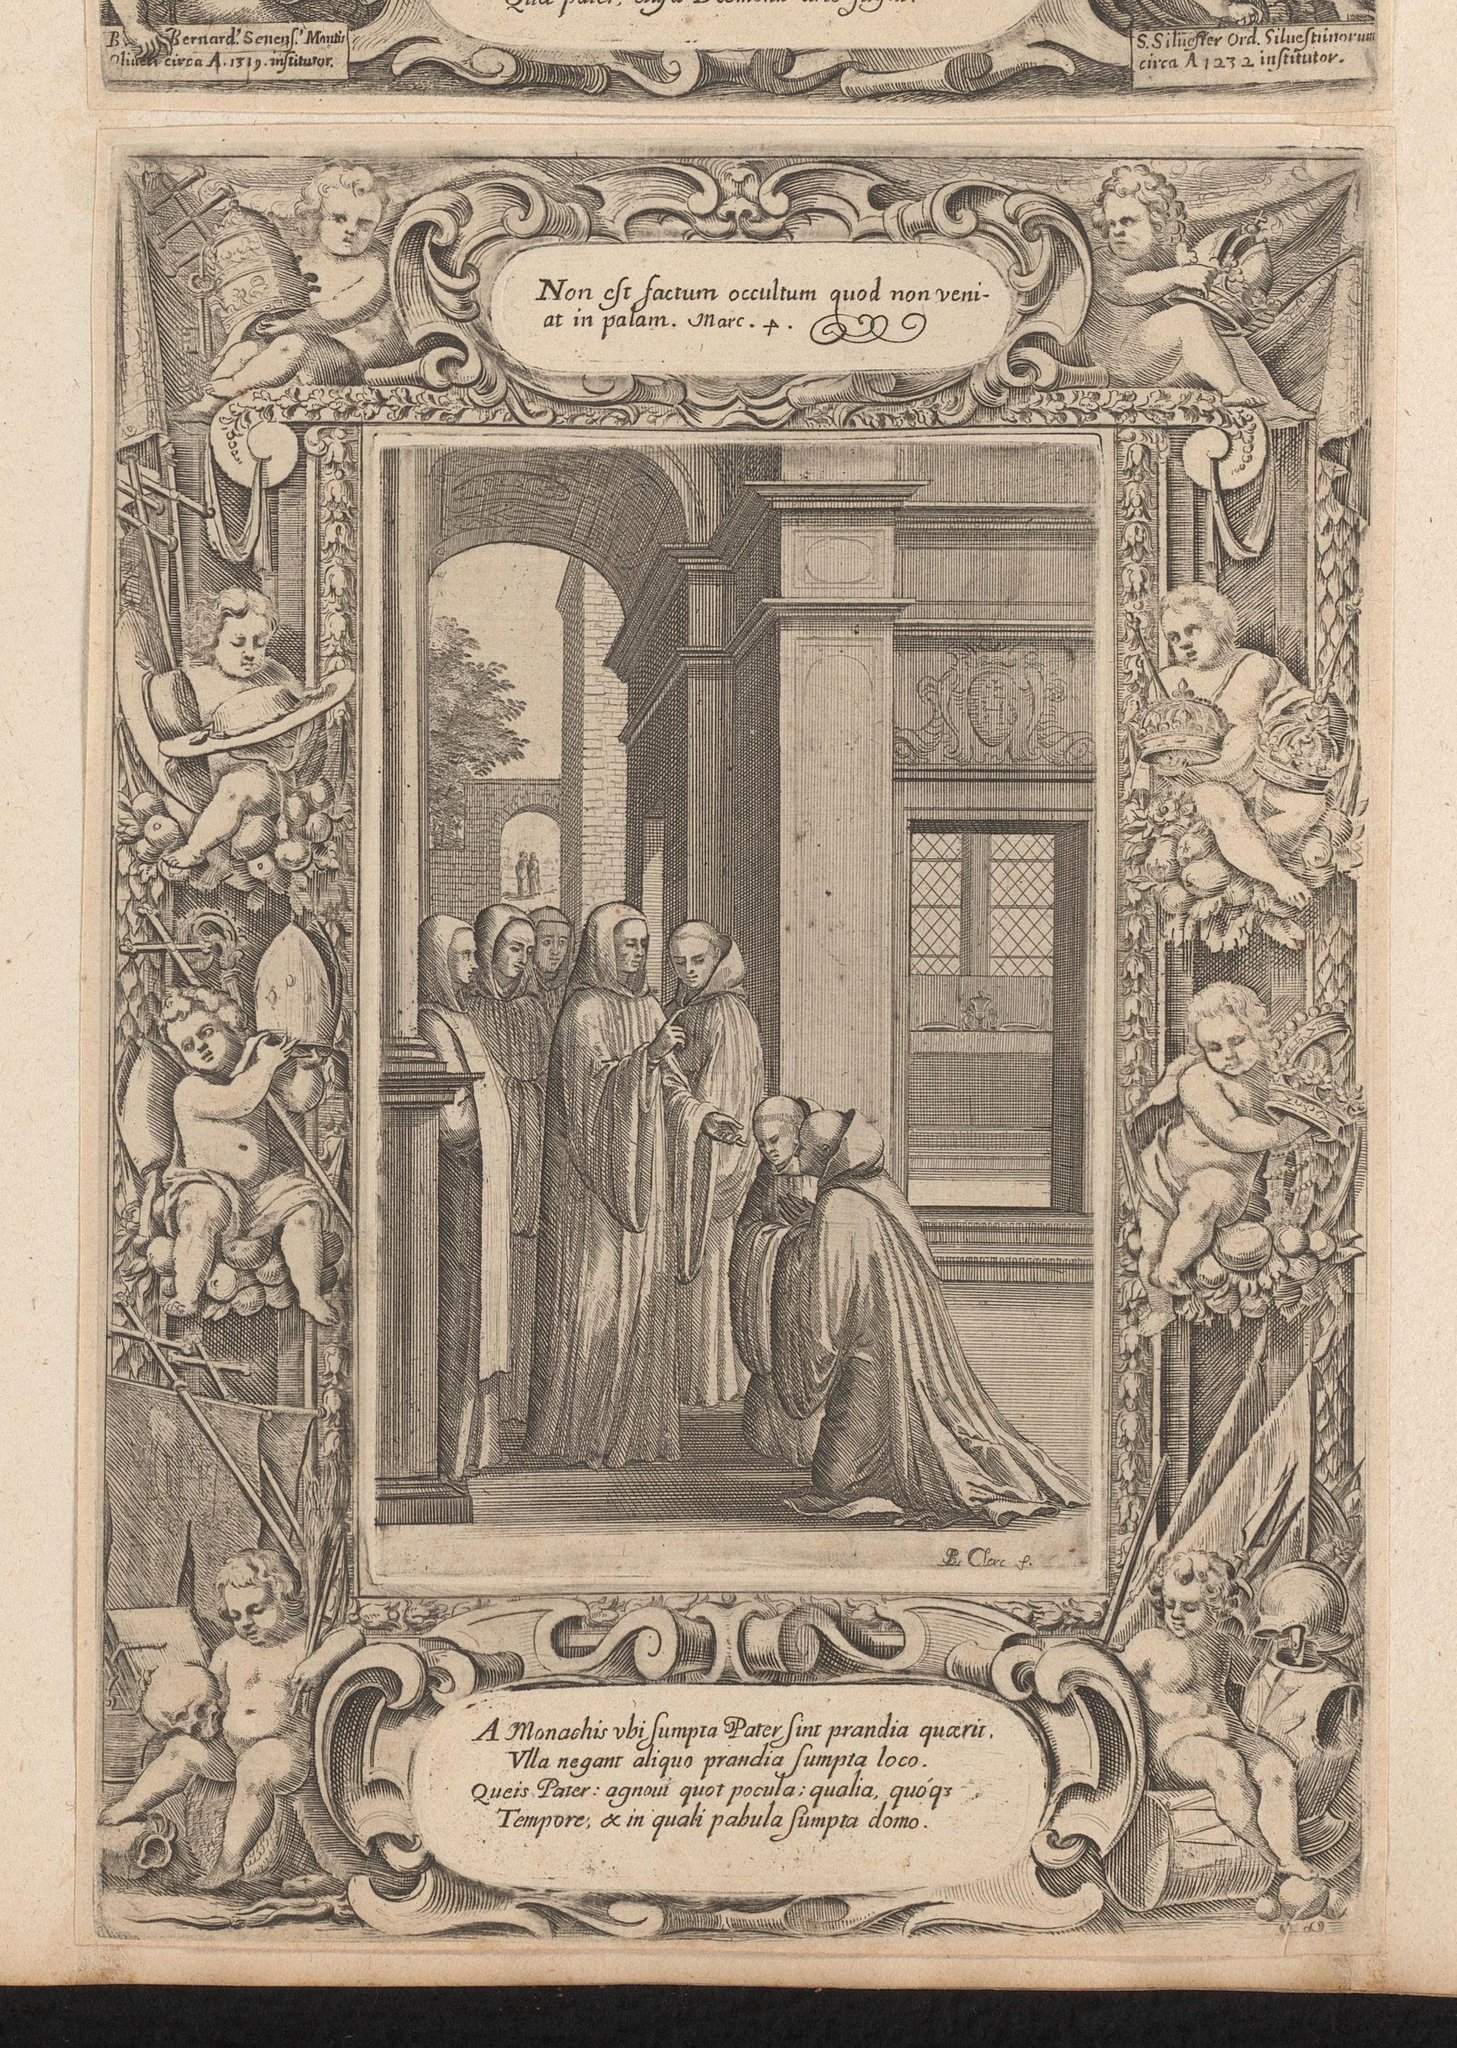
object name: print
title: Scènes uit het leven van H. Benedictus van Nursia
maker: sébastien leclerc (i)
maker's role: print maker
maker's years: 1637-1714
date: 1658-1659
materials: paper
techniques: etching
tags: benedict of nurcia, abbot of monte cassino and founder of the benedictine order; possible attributes: aspergillum, book, cup (sometimes broken), raven with loaf, sieve (or tray)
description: Maakt deel uit van een serie bestaande uit 33 prenten met voorstellingen uit het leven van de Heilige Benedictus van Nursia in ornamentele cartouches, uitgegeven in 1658-1659. De prenten zijn gedrukt van drie afzonderlijke platen bestaande uit de voorstelling, de cartouche en de tekst.